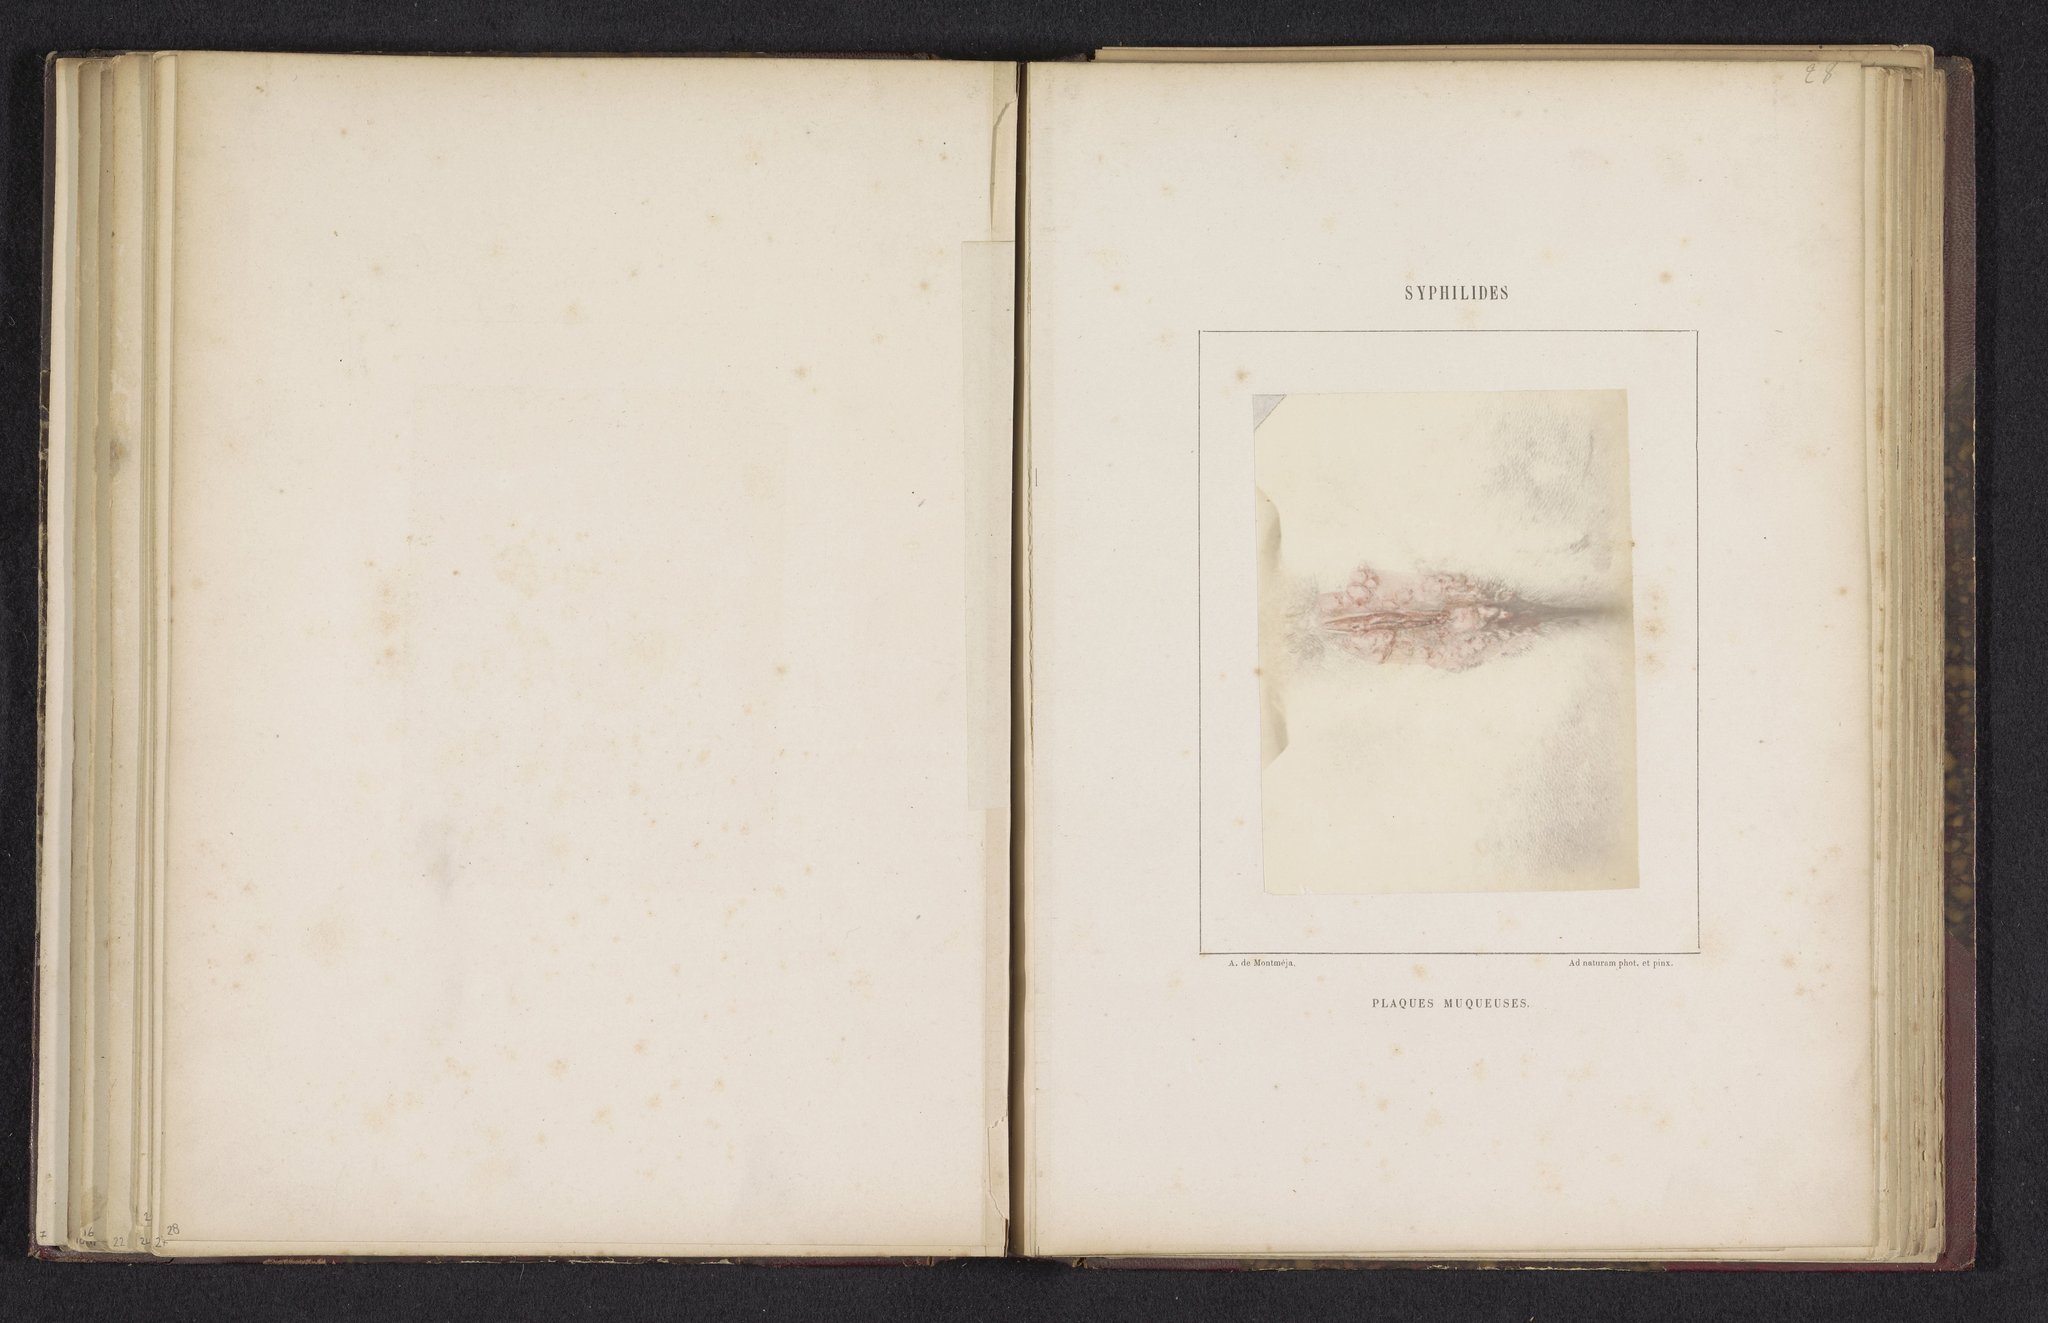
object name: photograph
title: Plaque muqueses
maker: a. de montméja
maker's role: arts, fotograaf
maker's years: 1841-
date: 1860-1868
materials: photographic support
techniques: albumen print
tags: skin and venereal diseases: syphilis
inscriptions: number: ‘28’, inscription: ‘Syphilides’, inscription: ‘Ad naturam phot. et pinx.’